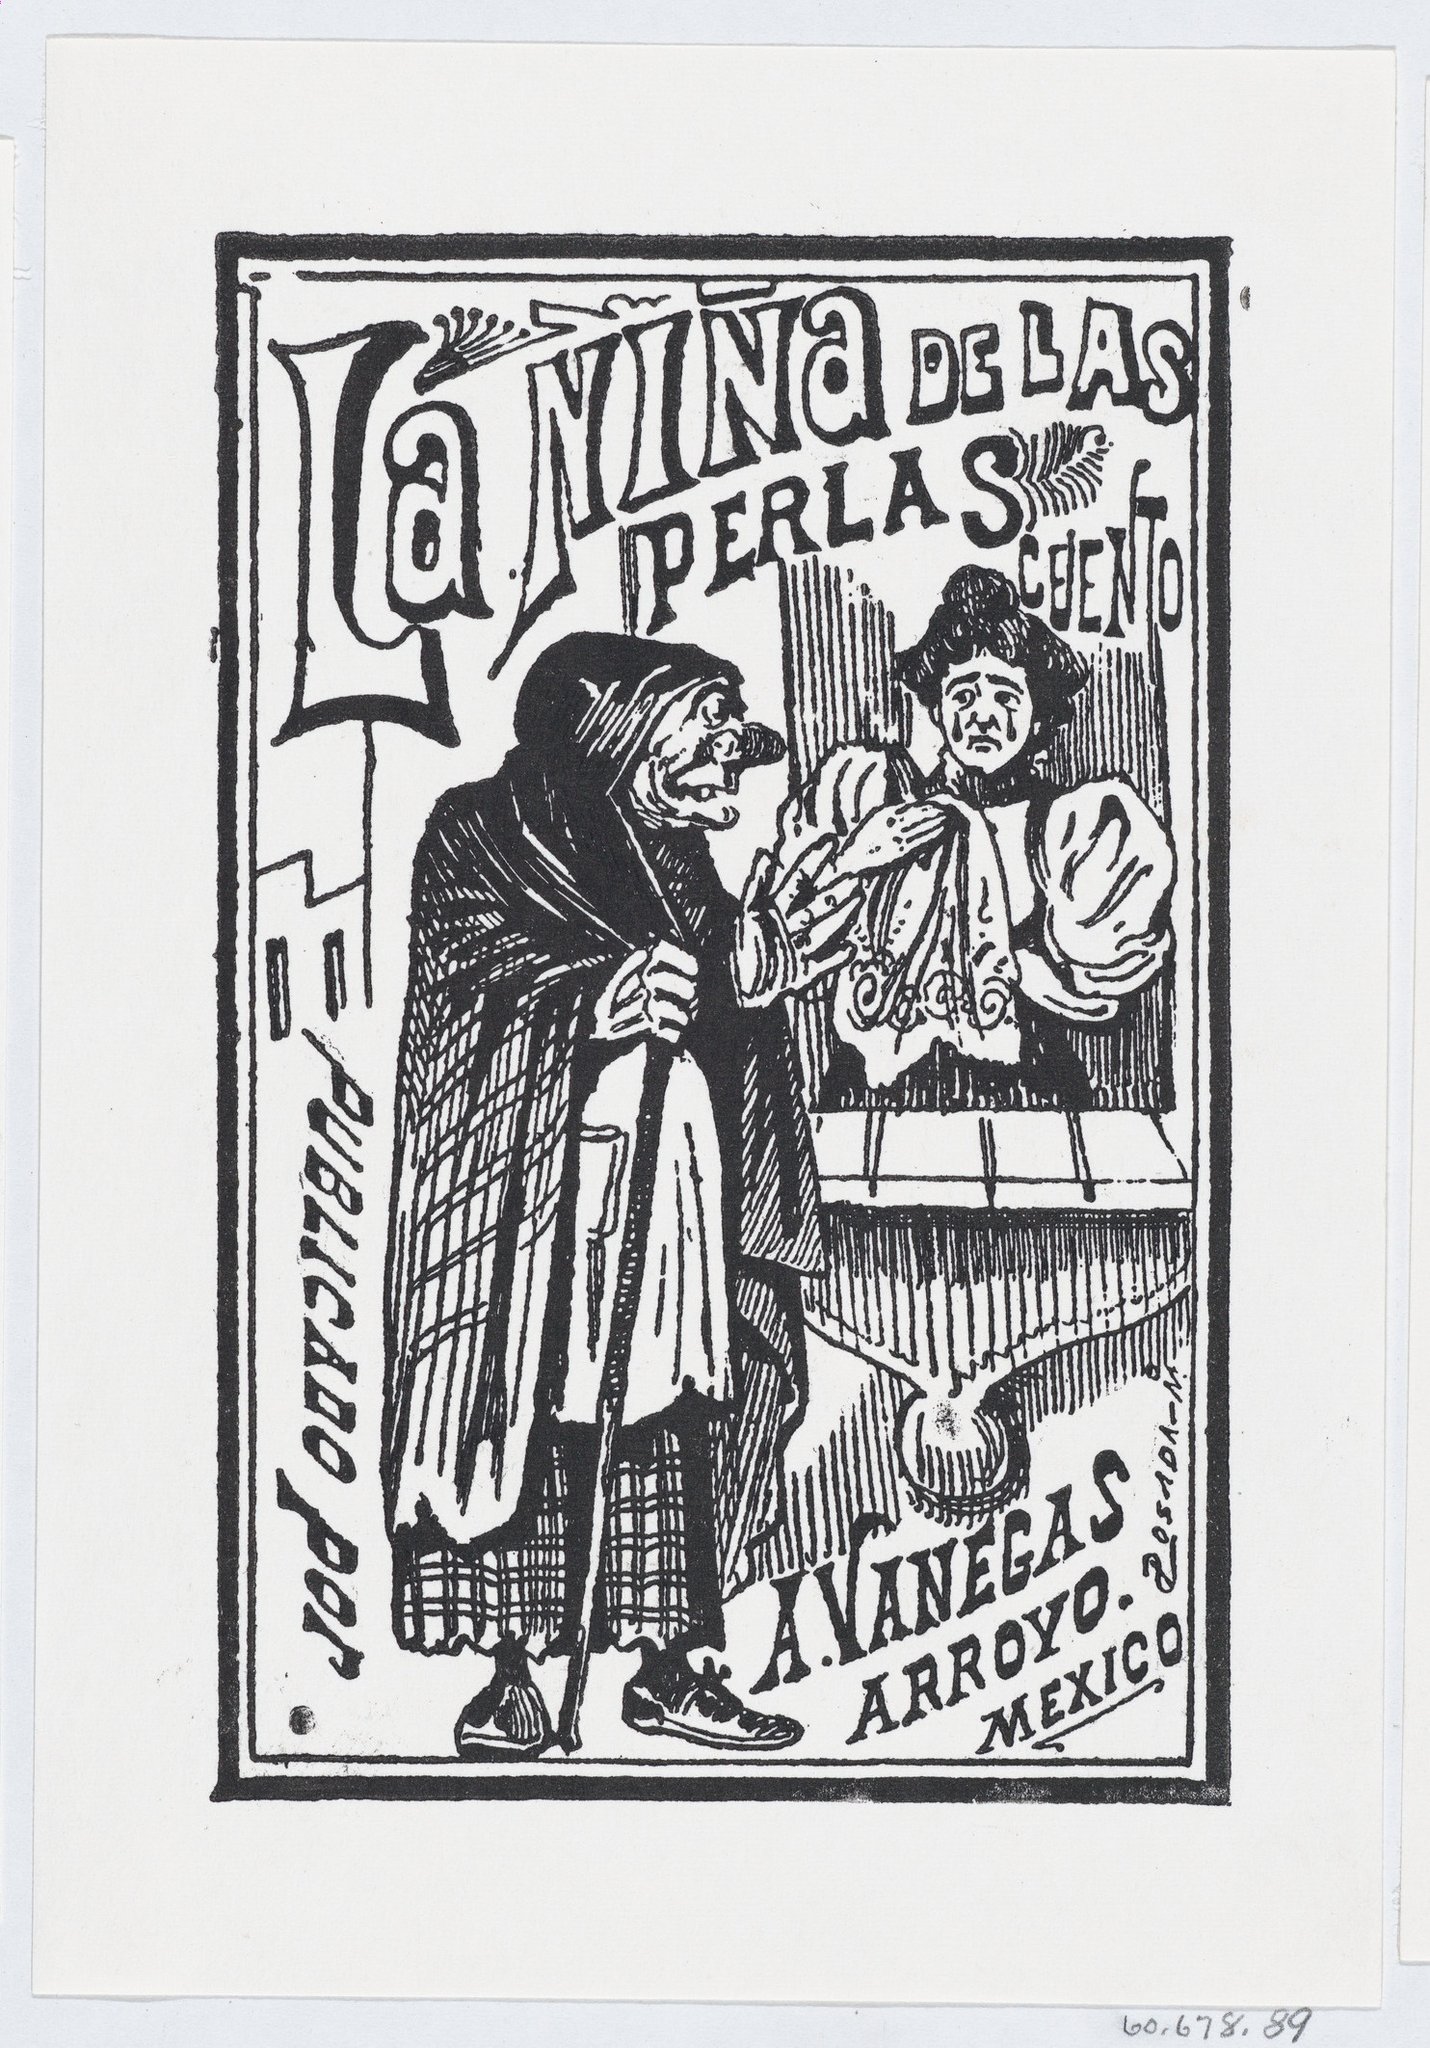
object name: print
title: A woman crying with a handkerchief in her hand talking to an old hag, illustration for 'La Niña de las Perlas, published by Antonio Vanegas Arroyo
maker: josé guadalupe posada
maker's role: artist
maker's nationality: mexican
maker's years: 1852-1913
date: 1880-1910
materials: metal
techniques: engraving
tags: women